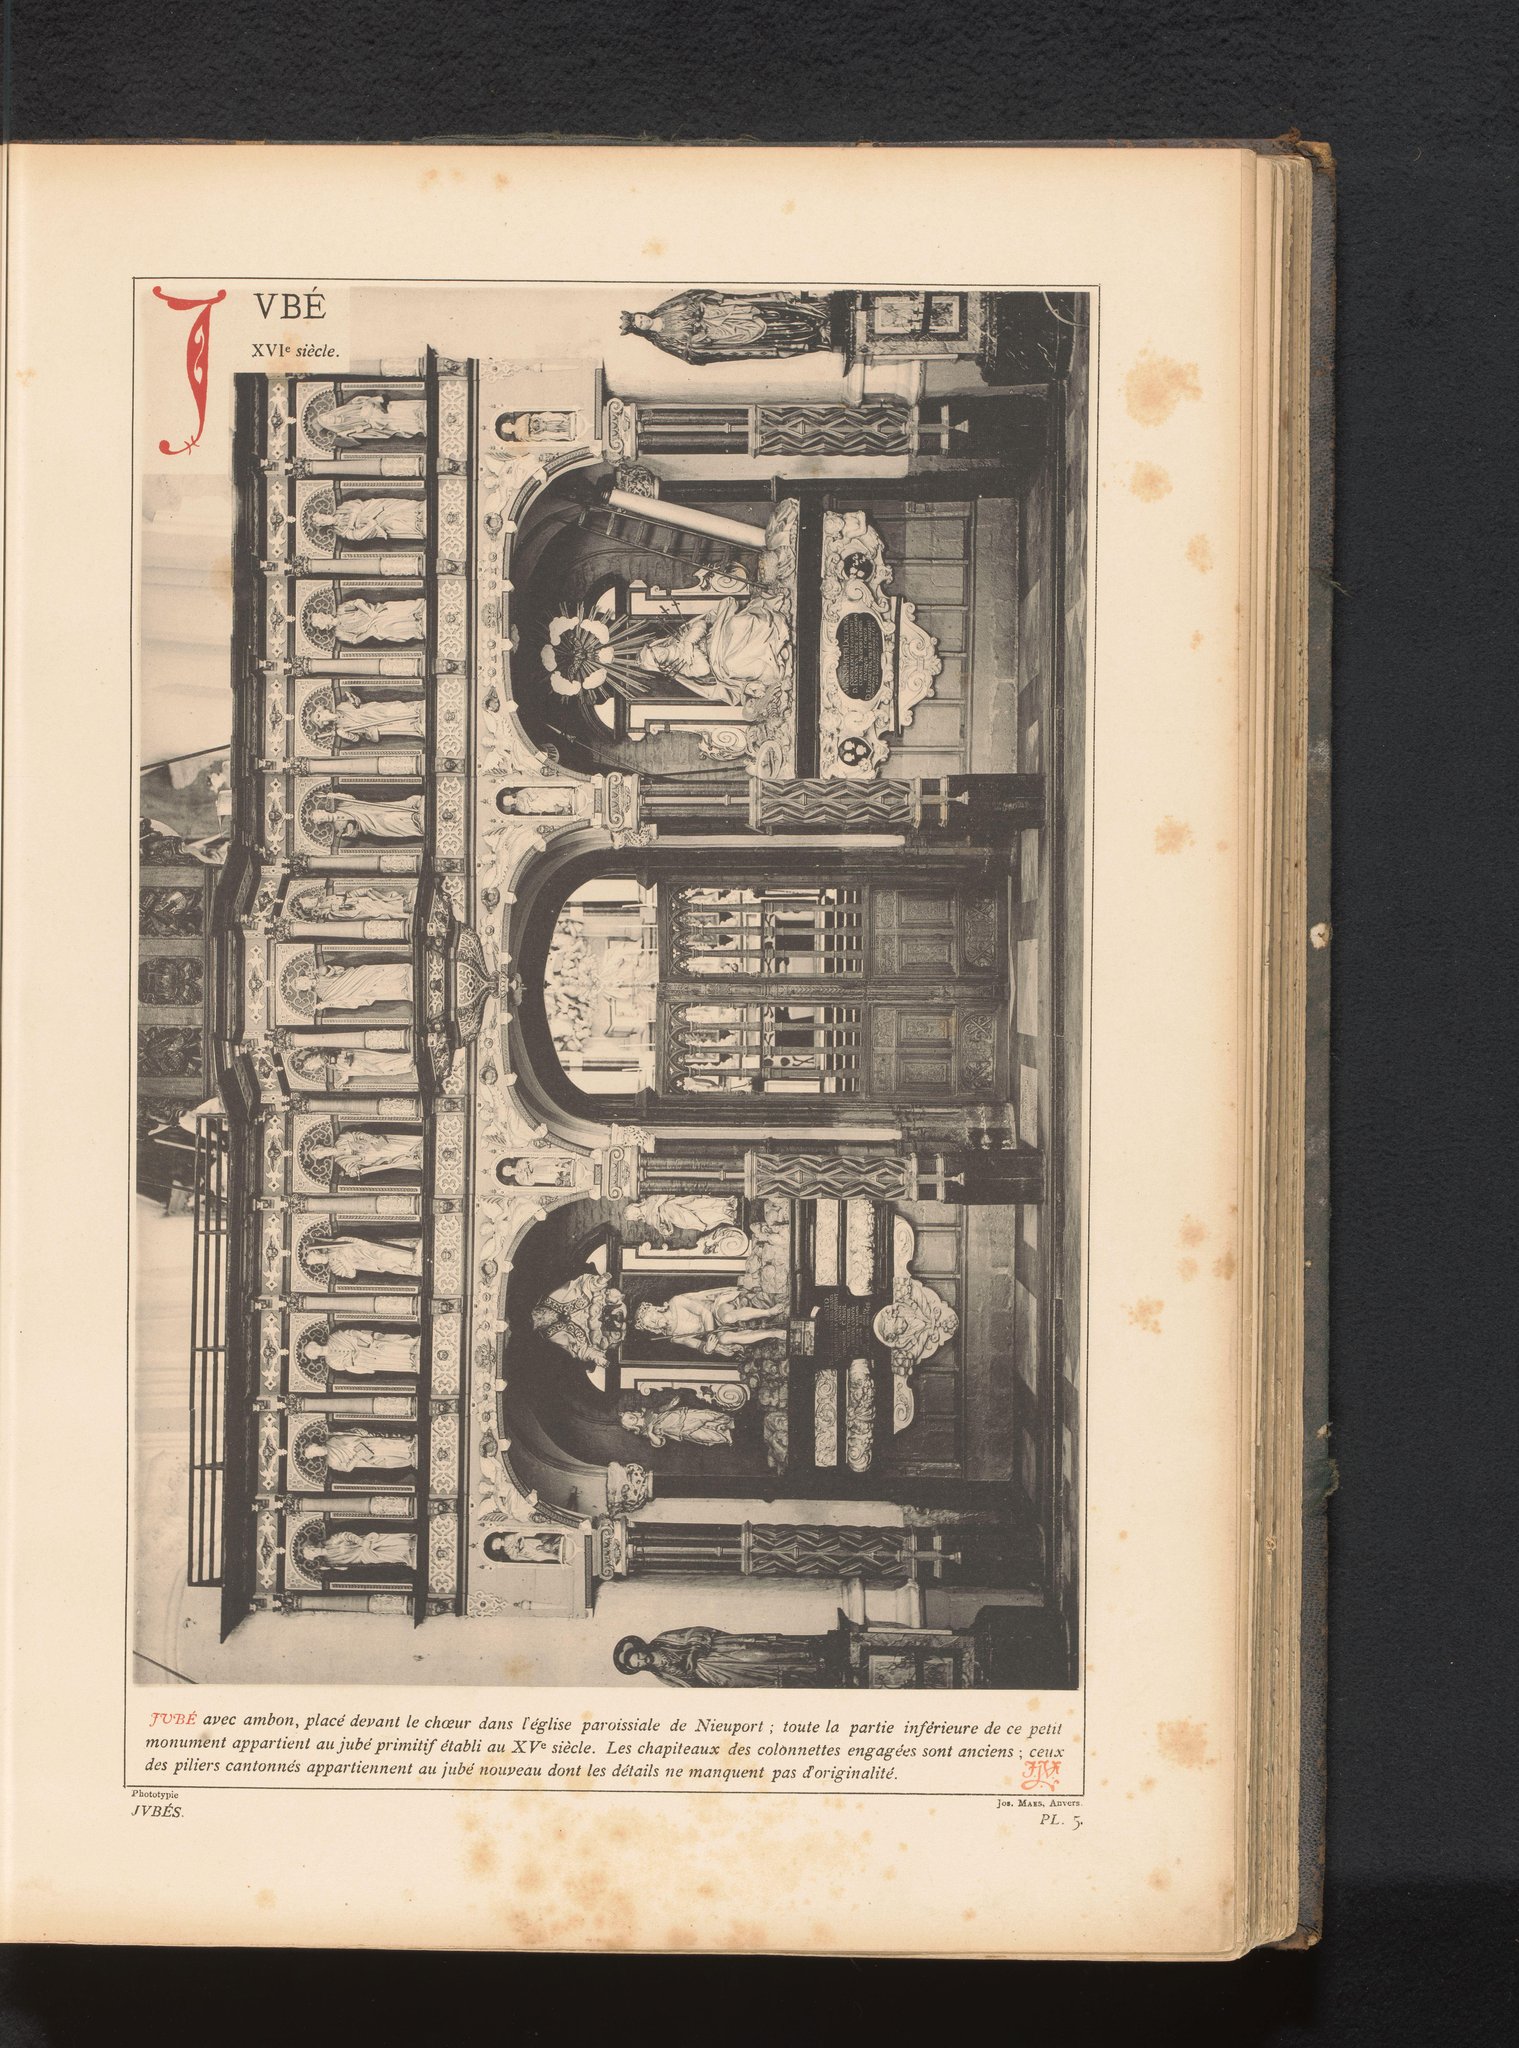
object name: page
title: Jubé, XVIe siècle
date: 1882-1887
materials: paper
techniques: photograph, photolithography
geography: church of our lady nieuwpoort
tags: parts of church interior: choir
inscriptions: inscription: ‘JUBÉ avec ambon (...)’, monogram: ‘JJvY’, inscription: ‘JUBÉS. - PL. 5.’